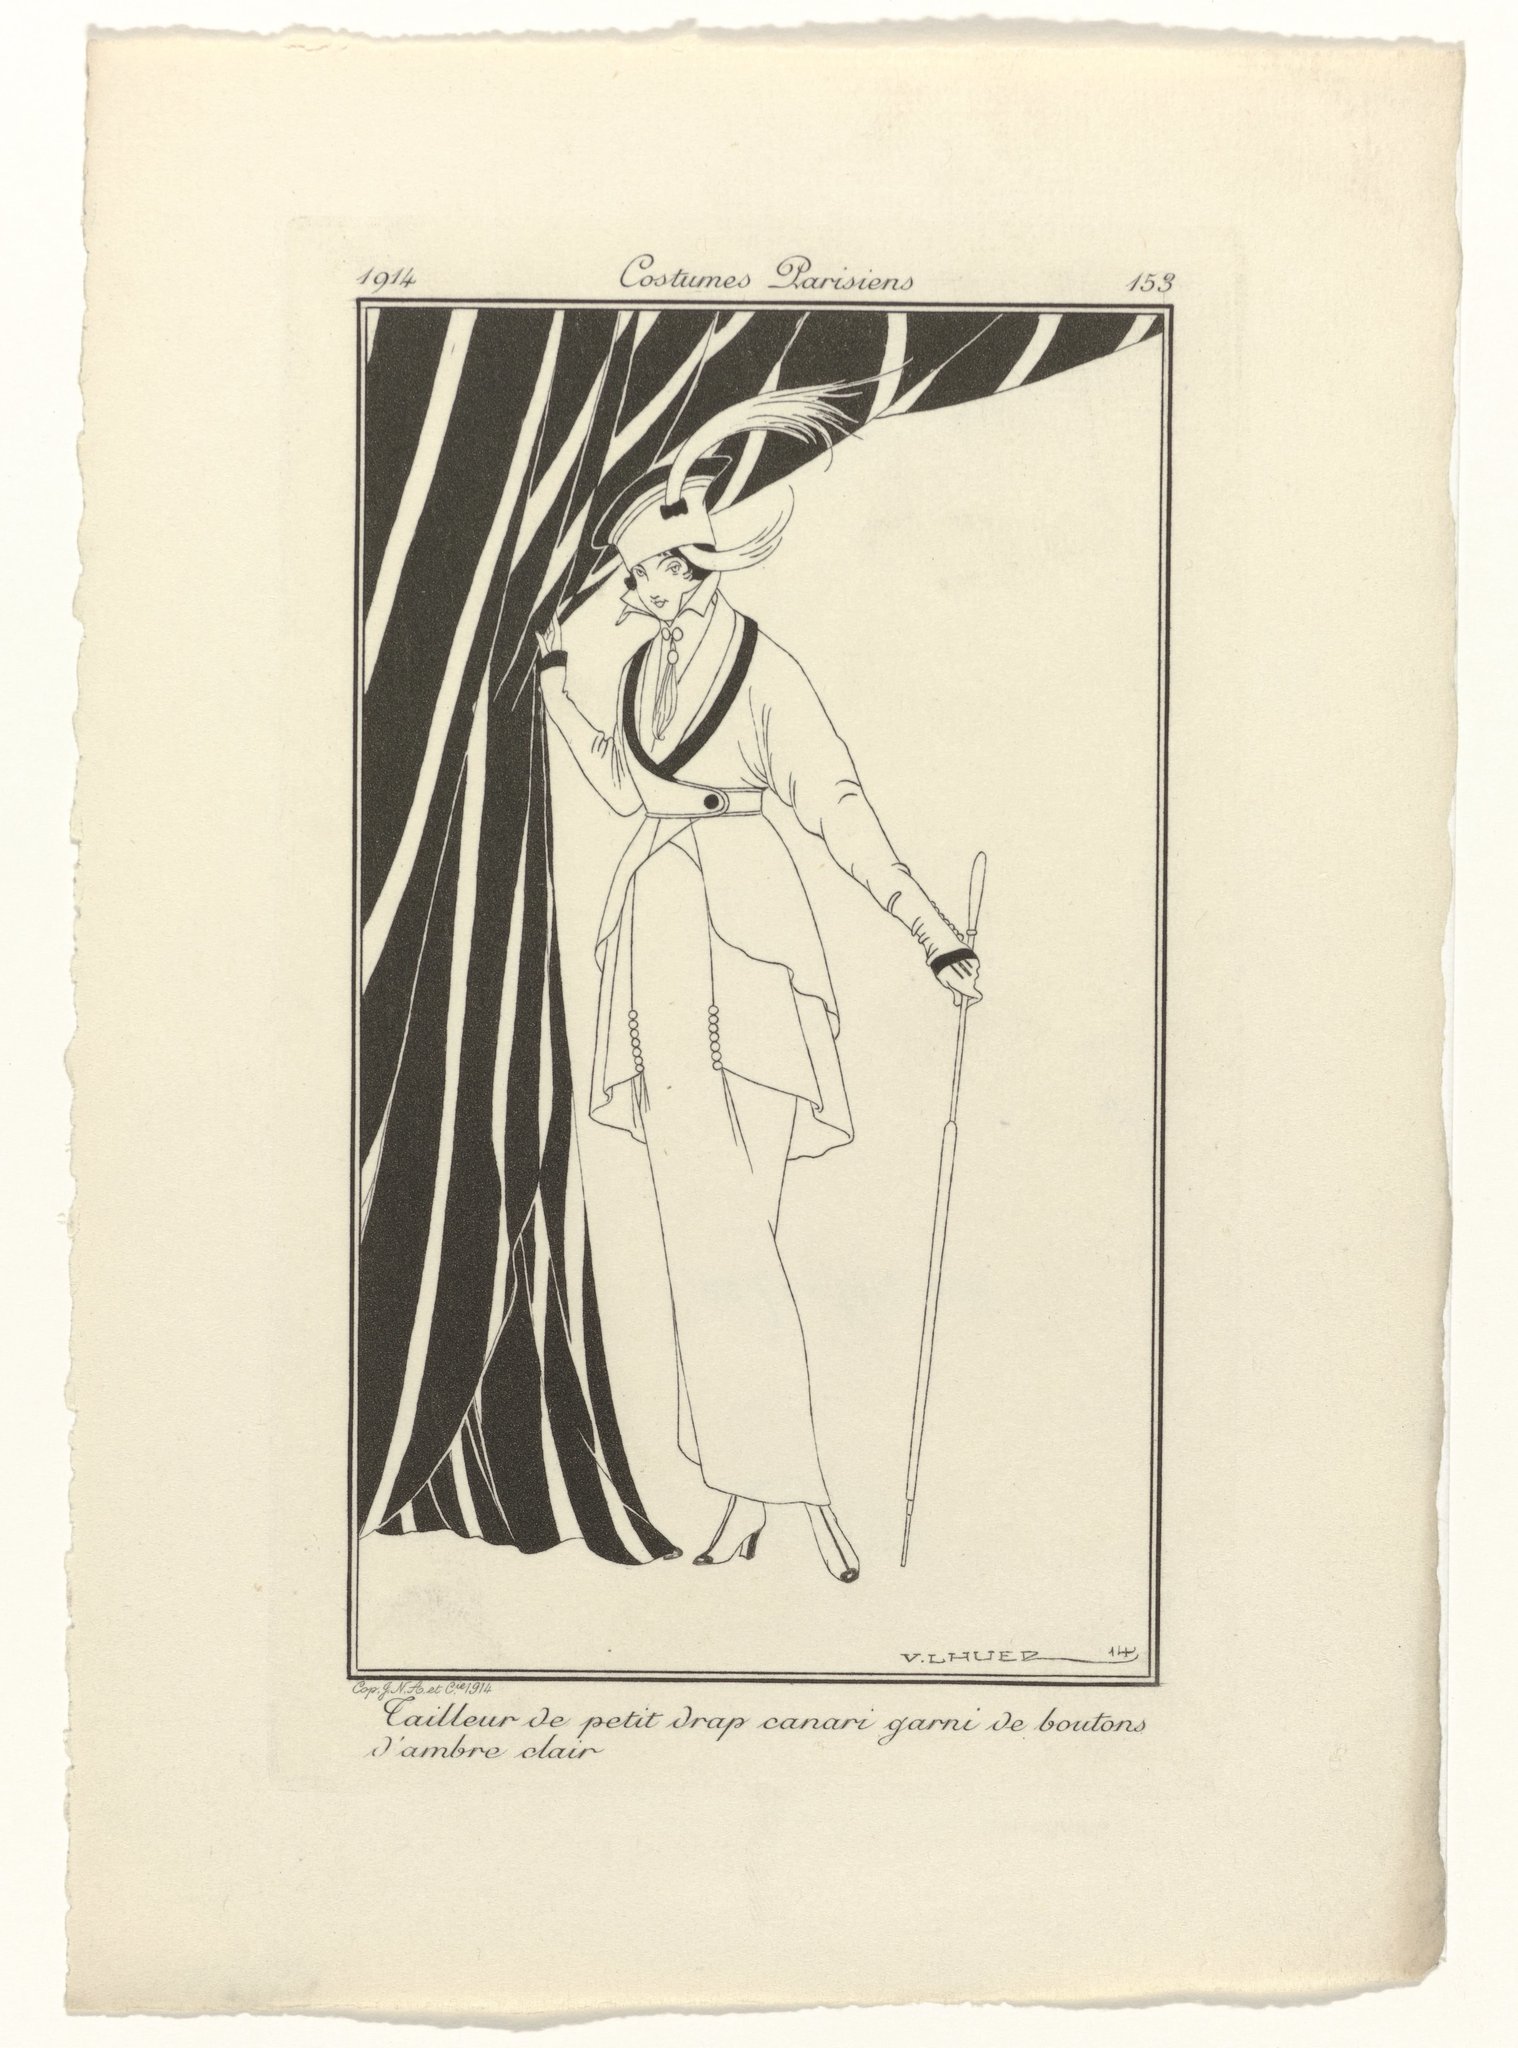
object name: fashion print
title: Journal des Dames et des Modes, Costumes Parisiens, 1914, No. 153 : Tailleur de petit drap (...)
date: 1914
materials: paper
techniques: engraving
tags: curtains, clothing for the upper part of the body (+ women's clothes), walking-stick, staff, cane (+ women's clothes), ensembles of pieces of clothing (suit) (+ women's clothes), coat (+ women's clothes), head-gear (+ women's clothes), fashion plates, skirt (+ women's clothes)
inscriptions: inscription: ‘Cop. J. N. A. et Cie 1914’, title: ‘Costumes Parisiens’, caption: ‘Tailleur de petit drap canari garni de boutons d'ambre clair’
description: Mantelpak van kanariegeel laken, versierd met knopen van licht barnsteen. Proefdruk van een prent uit het modetijdschrift Journal des Dames et des Modes (1912-1914).